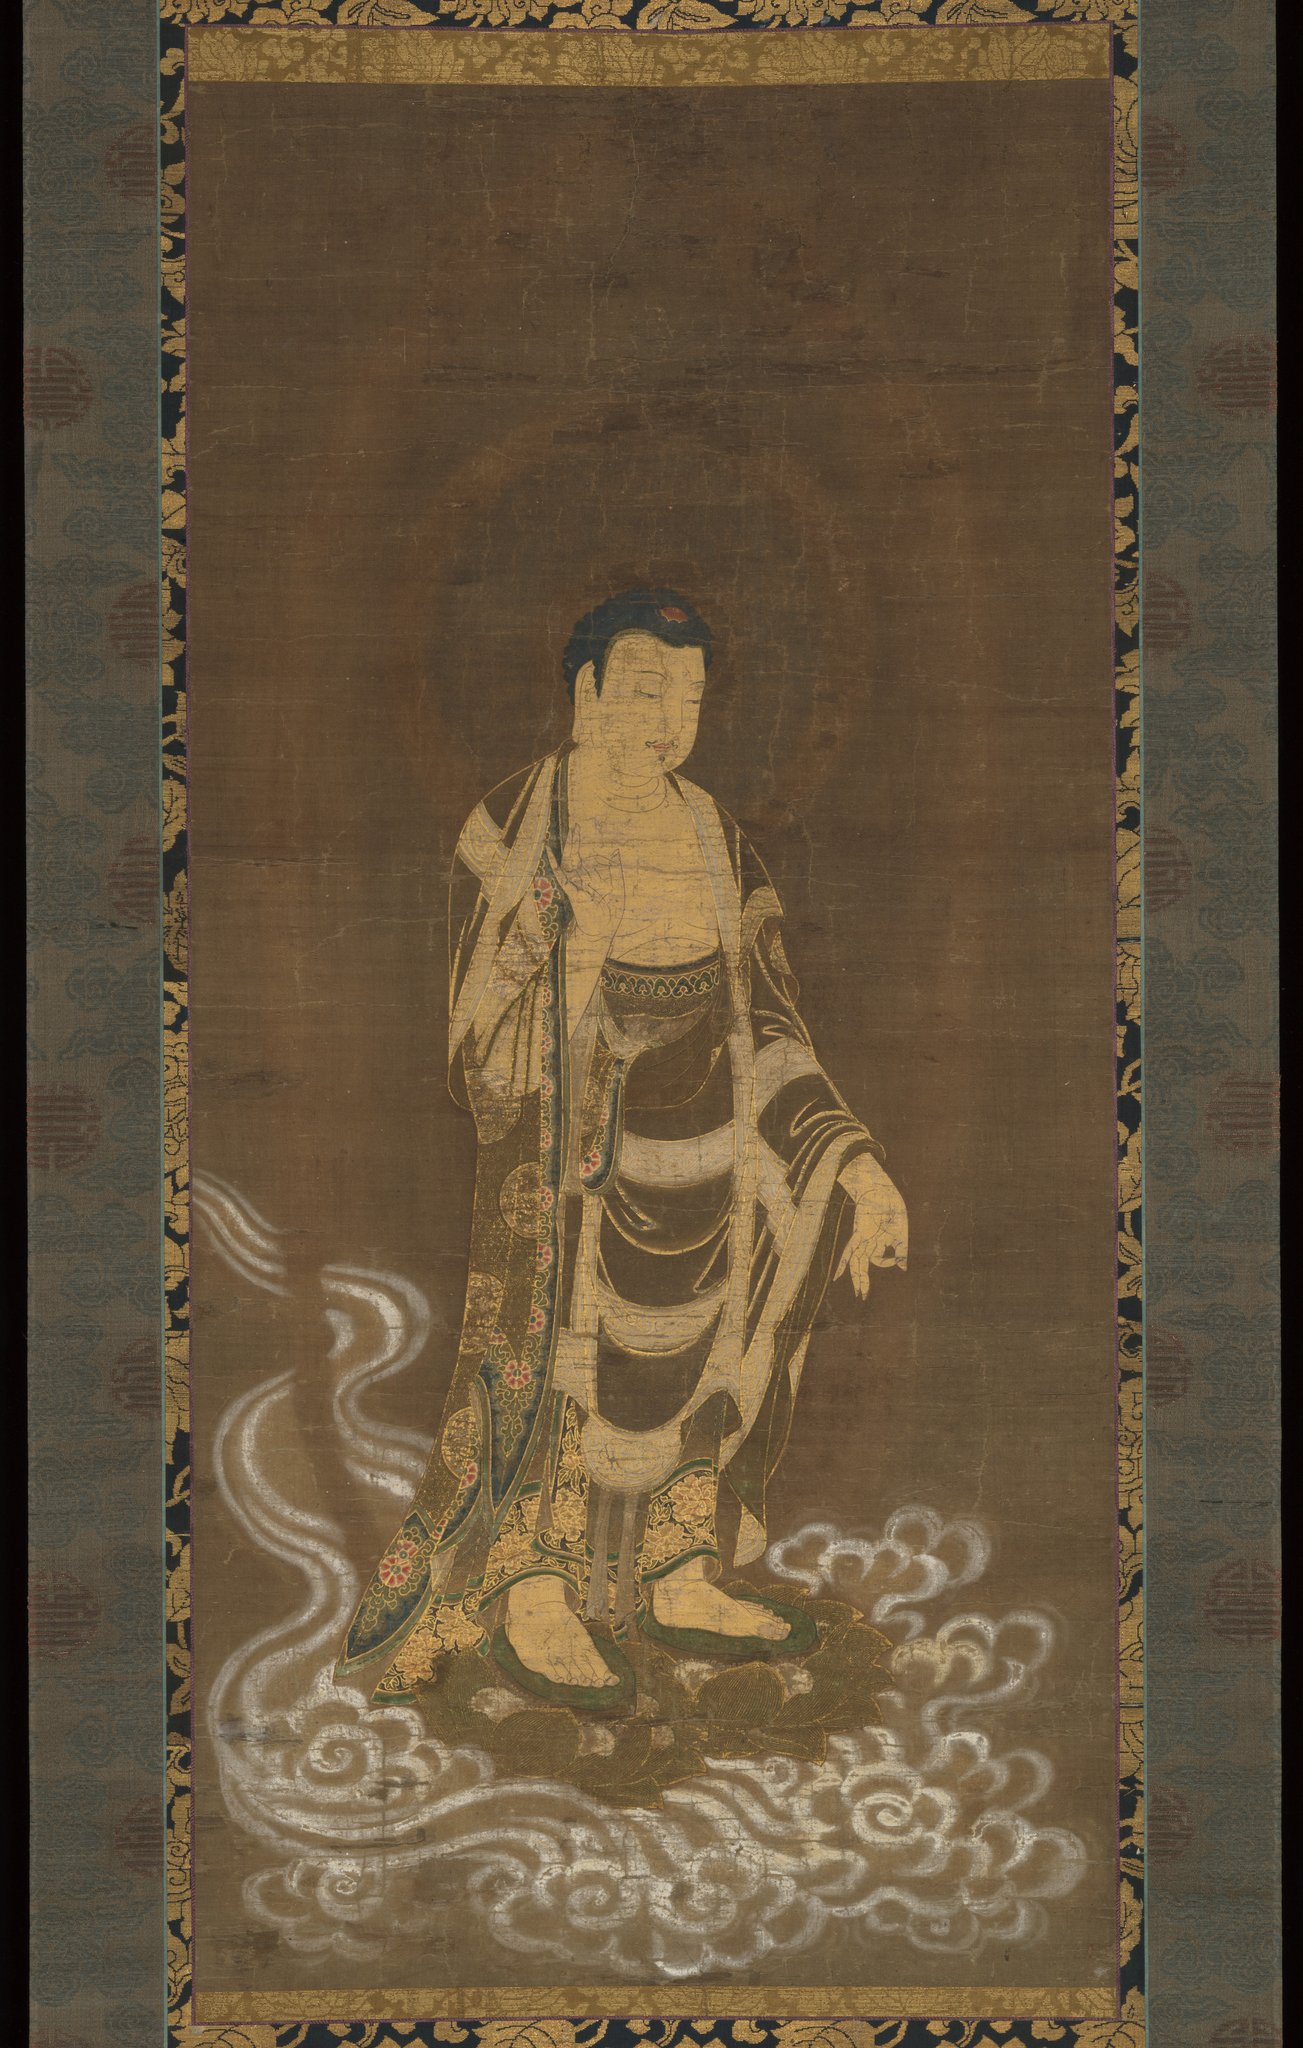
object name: hanging scroll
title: Welcoming Descent of Amida Buddha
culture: japanese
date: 1401-1600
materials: gold, ink, silk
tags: buddha